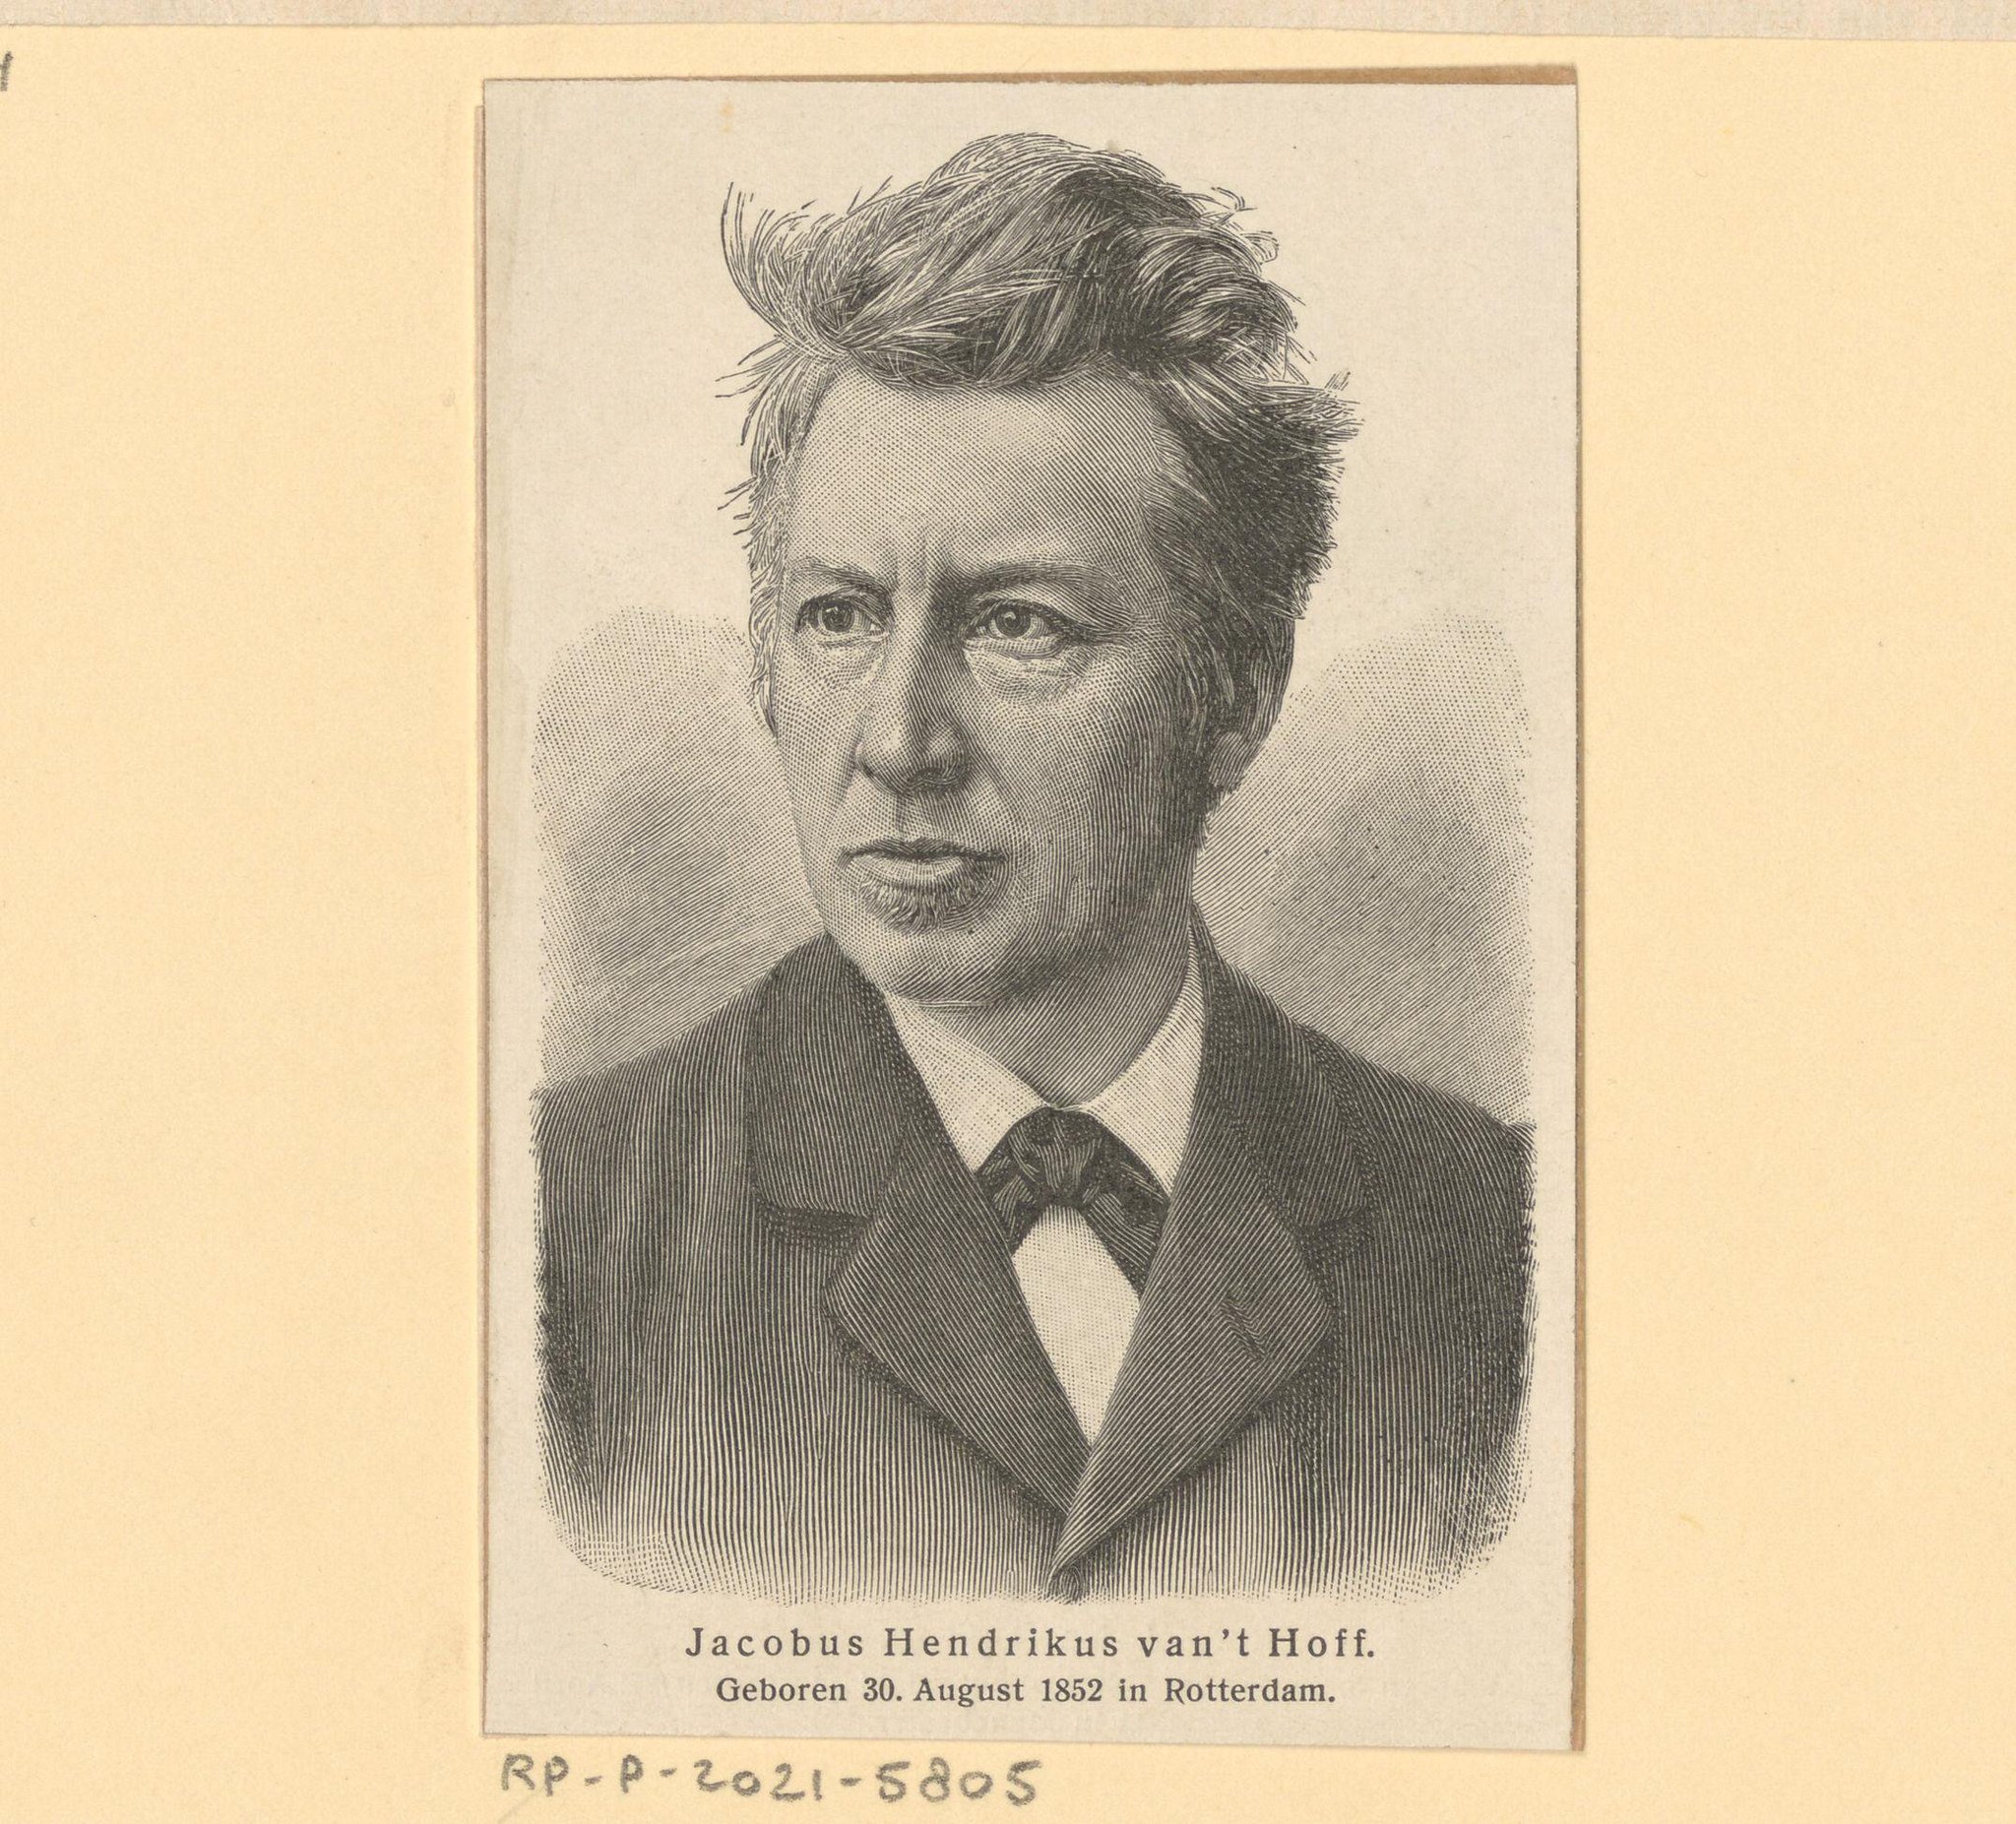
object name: print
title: Portret van Jacobus Henricus van 't Hoff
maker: Anonymous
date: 1900-1915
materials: paper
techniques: letterpress printing, engraving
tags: rotterdam, historical persons, chemistry (+ scholar, scientist (at work))